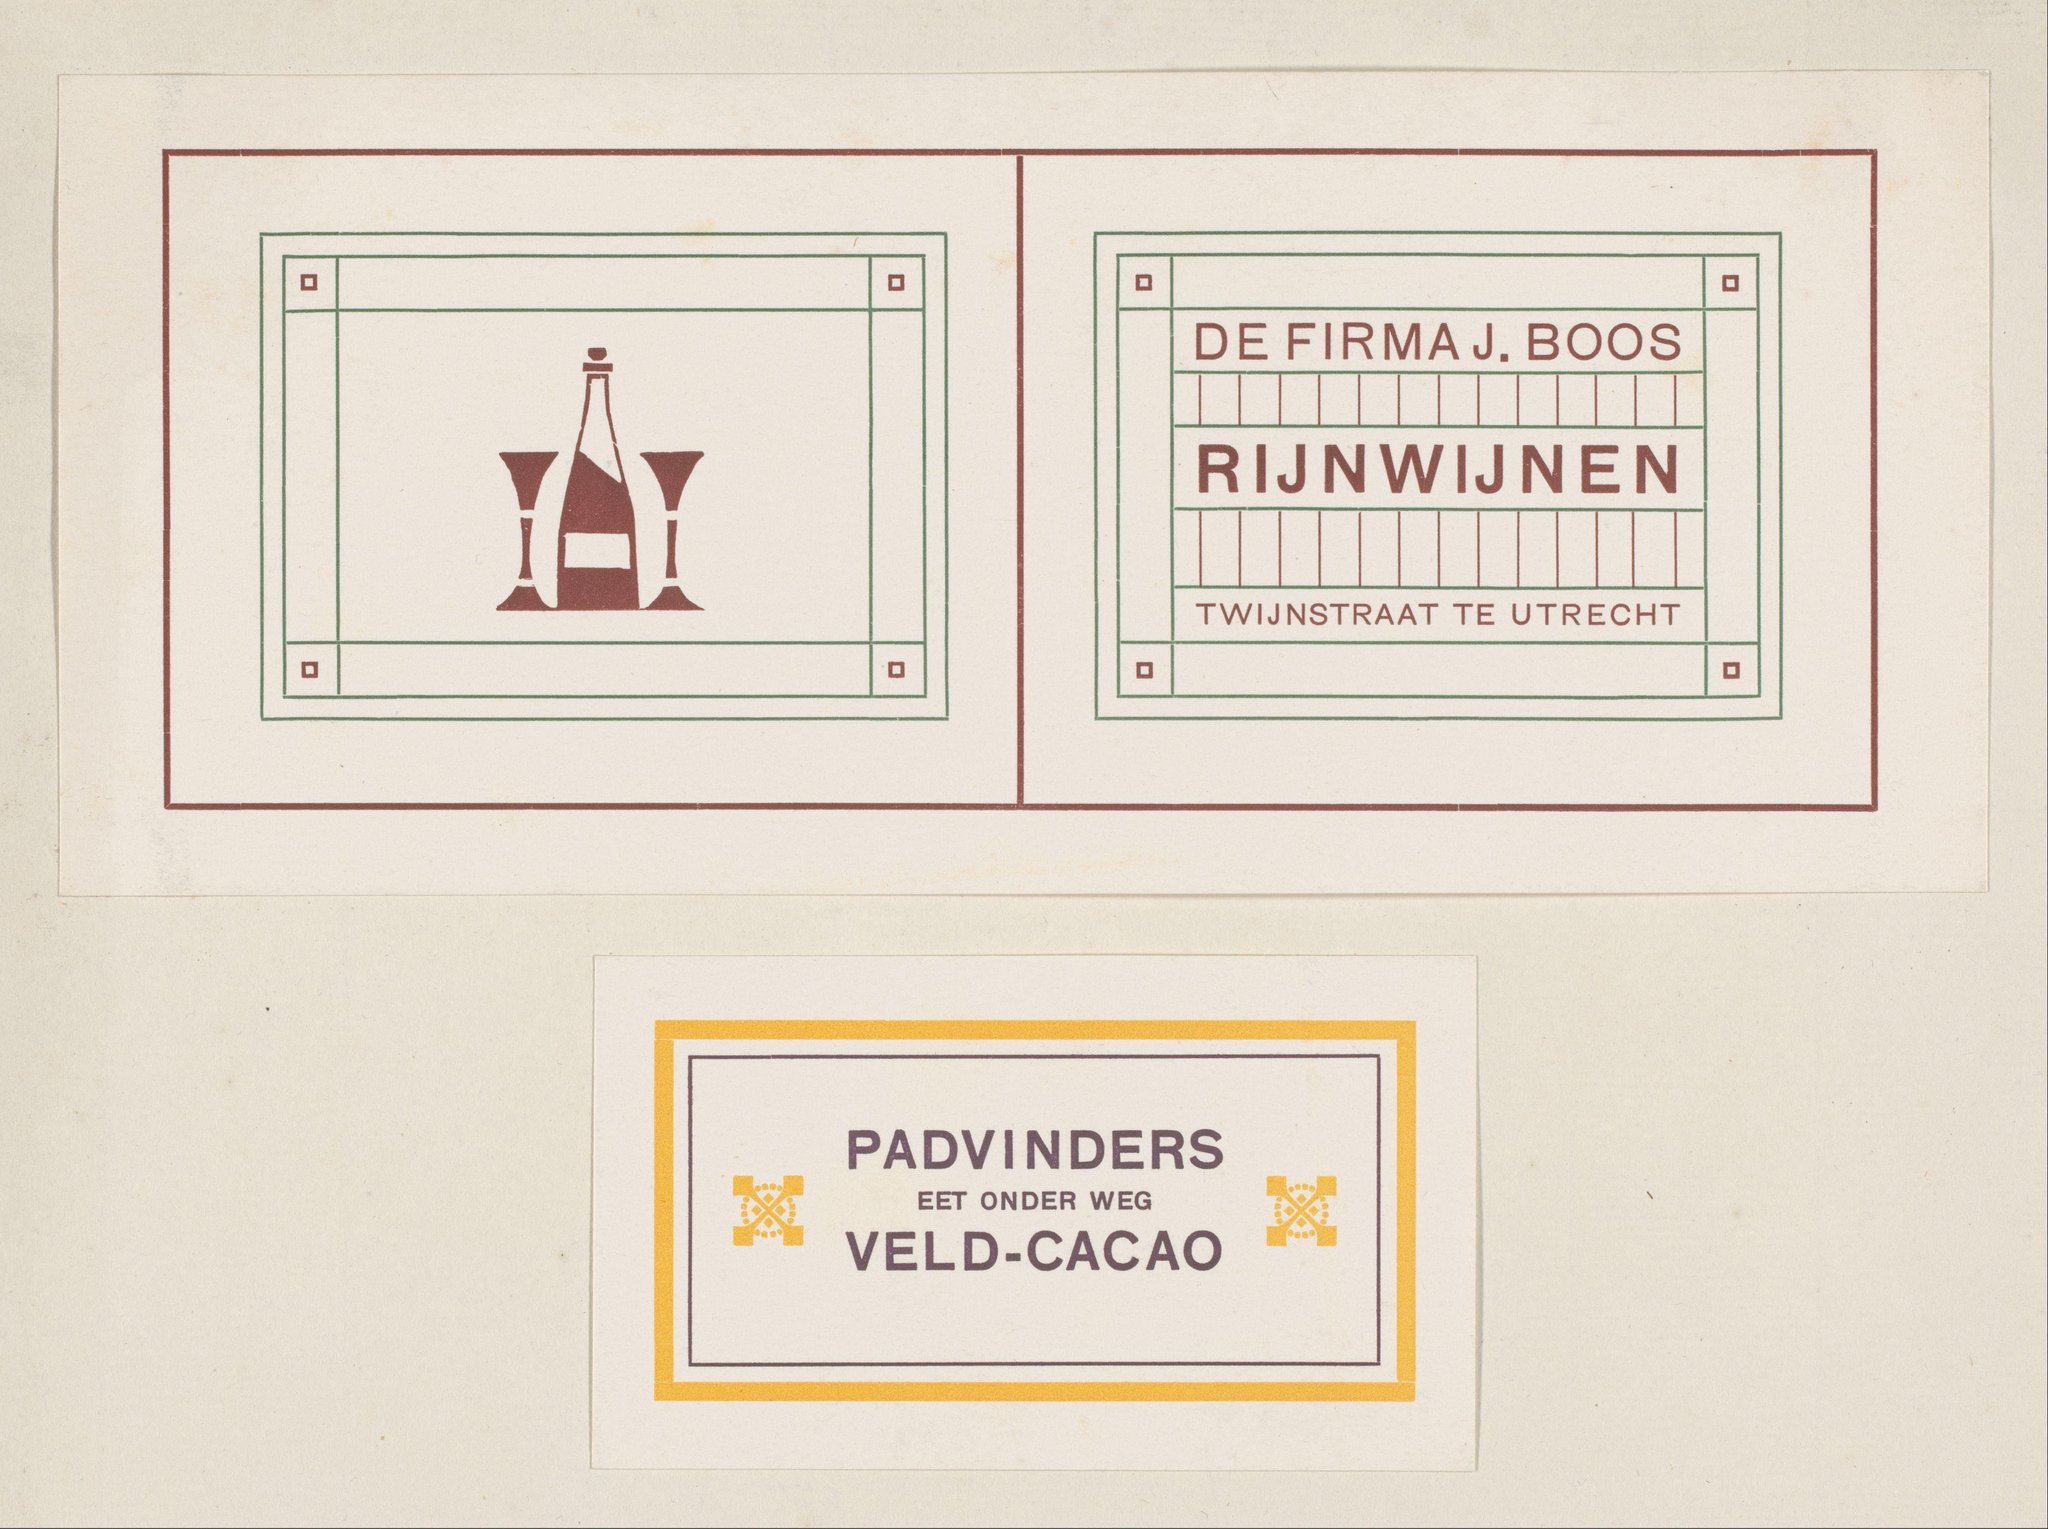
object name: photomechanical print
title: Advertenties voor Rijnwijnen en Veld-cacao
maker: reinier willem petrus de vries (1874-1953)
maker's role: draughtsman, print maker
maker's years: 1874-1953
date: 1884-1952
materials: paper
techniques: printing block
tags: bottle of wine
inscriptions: annotation: ‘de V’